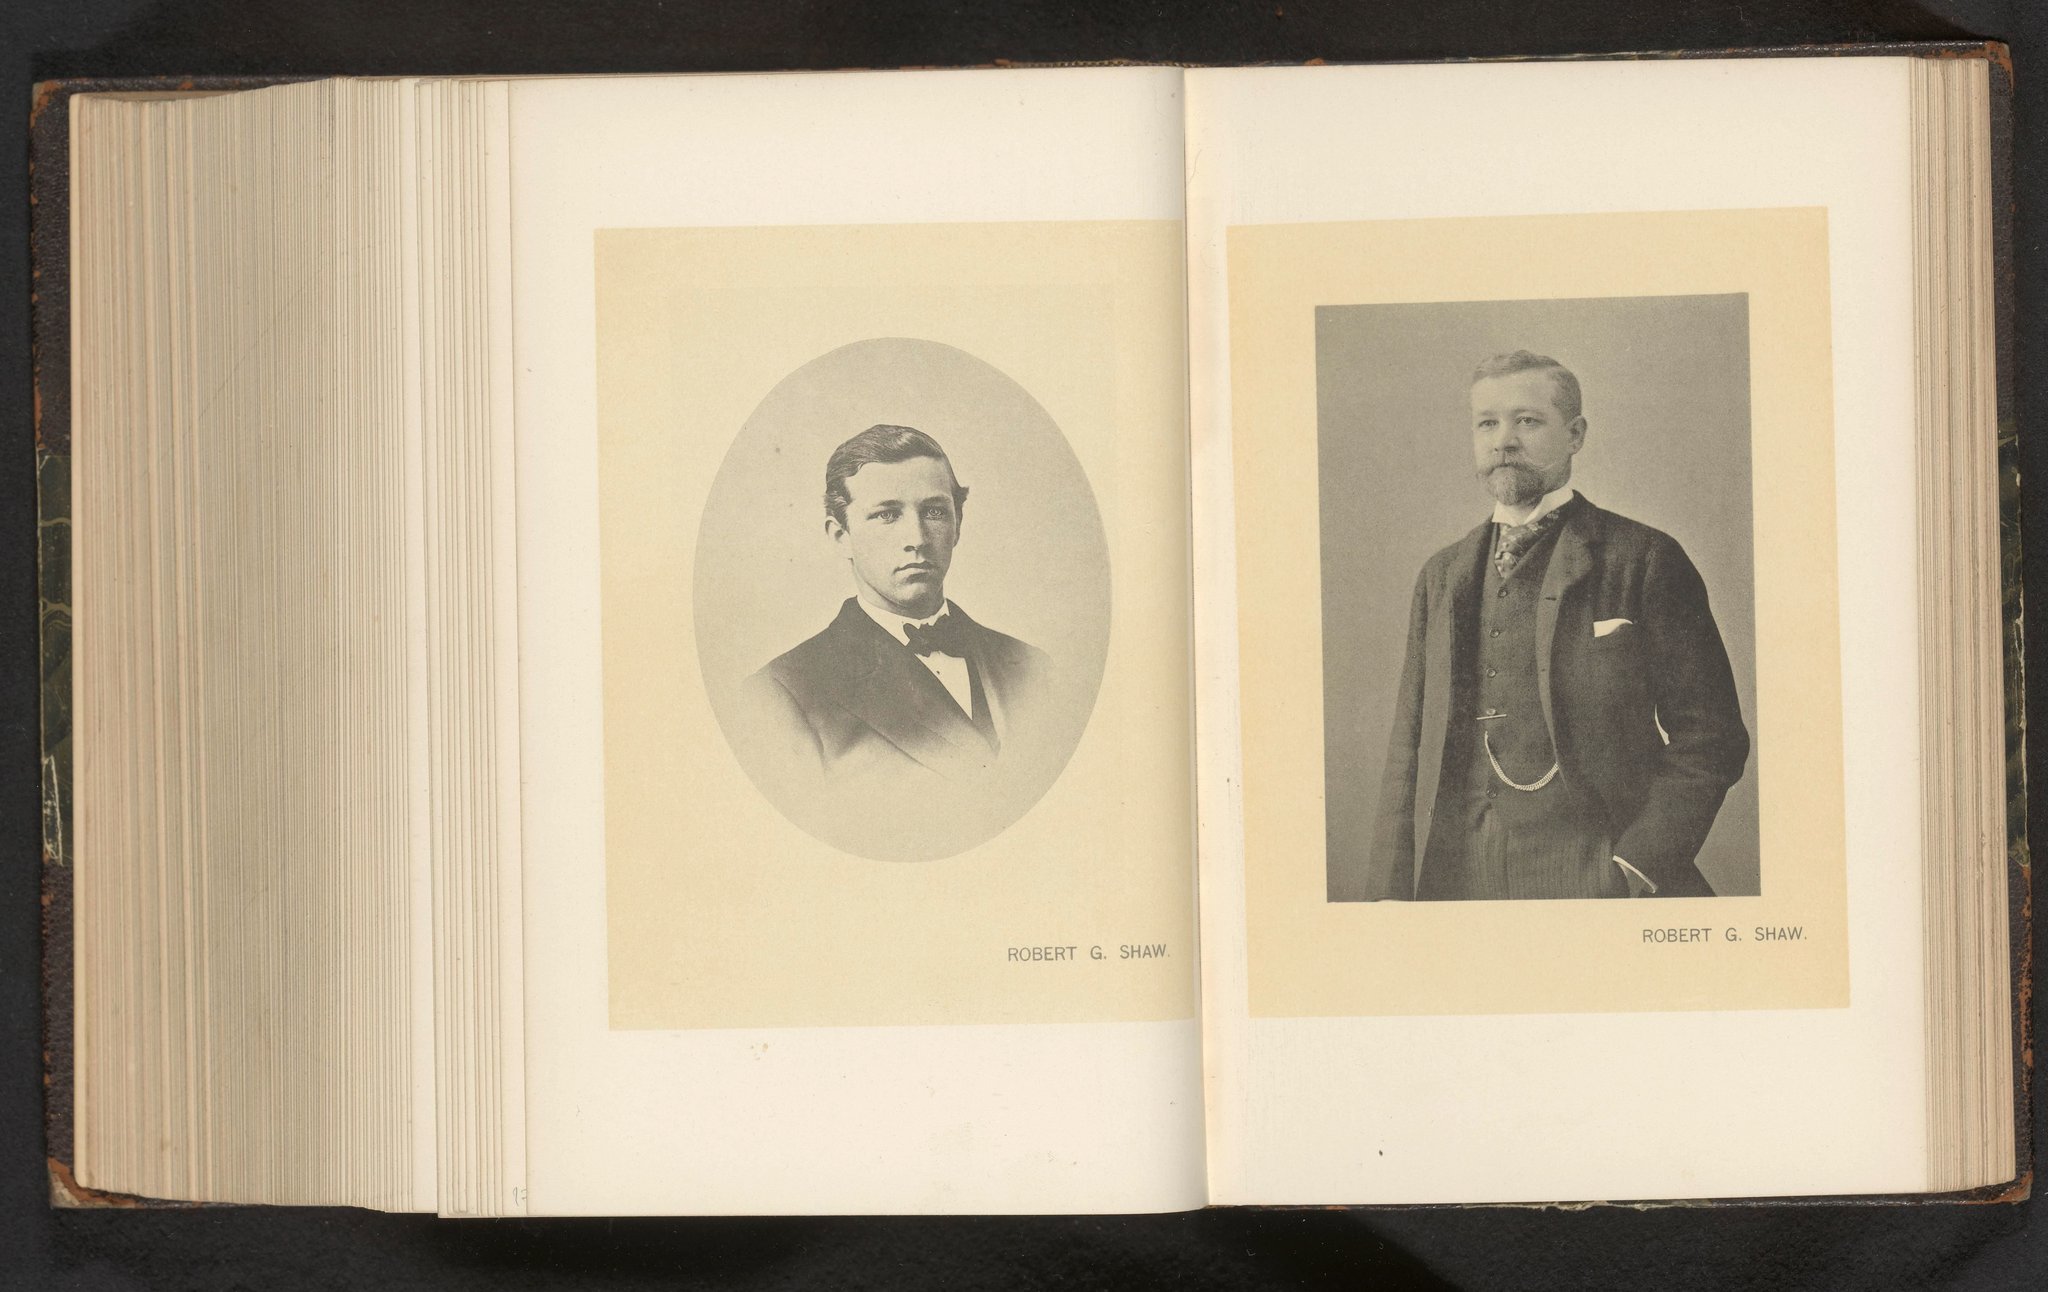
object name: photomechanical print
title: Robert G. Shaw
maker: Anonymous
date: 1889-1894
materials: paper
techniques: photoaquatint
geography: boston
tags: adult man